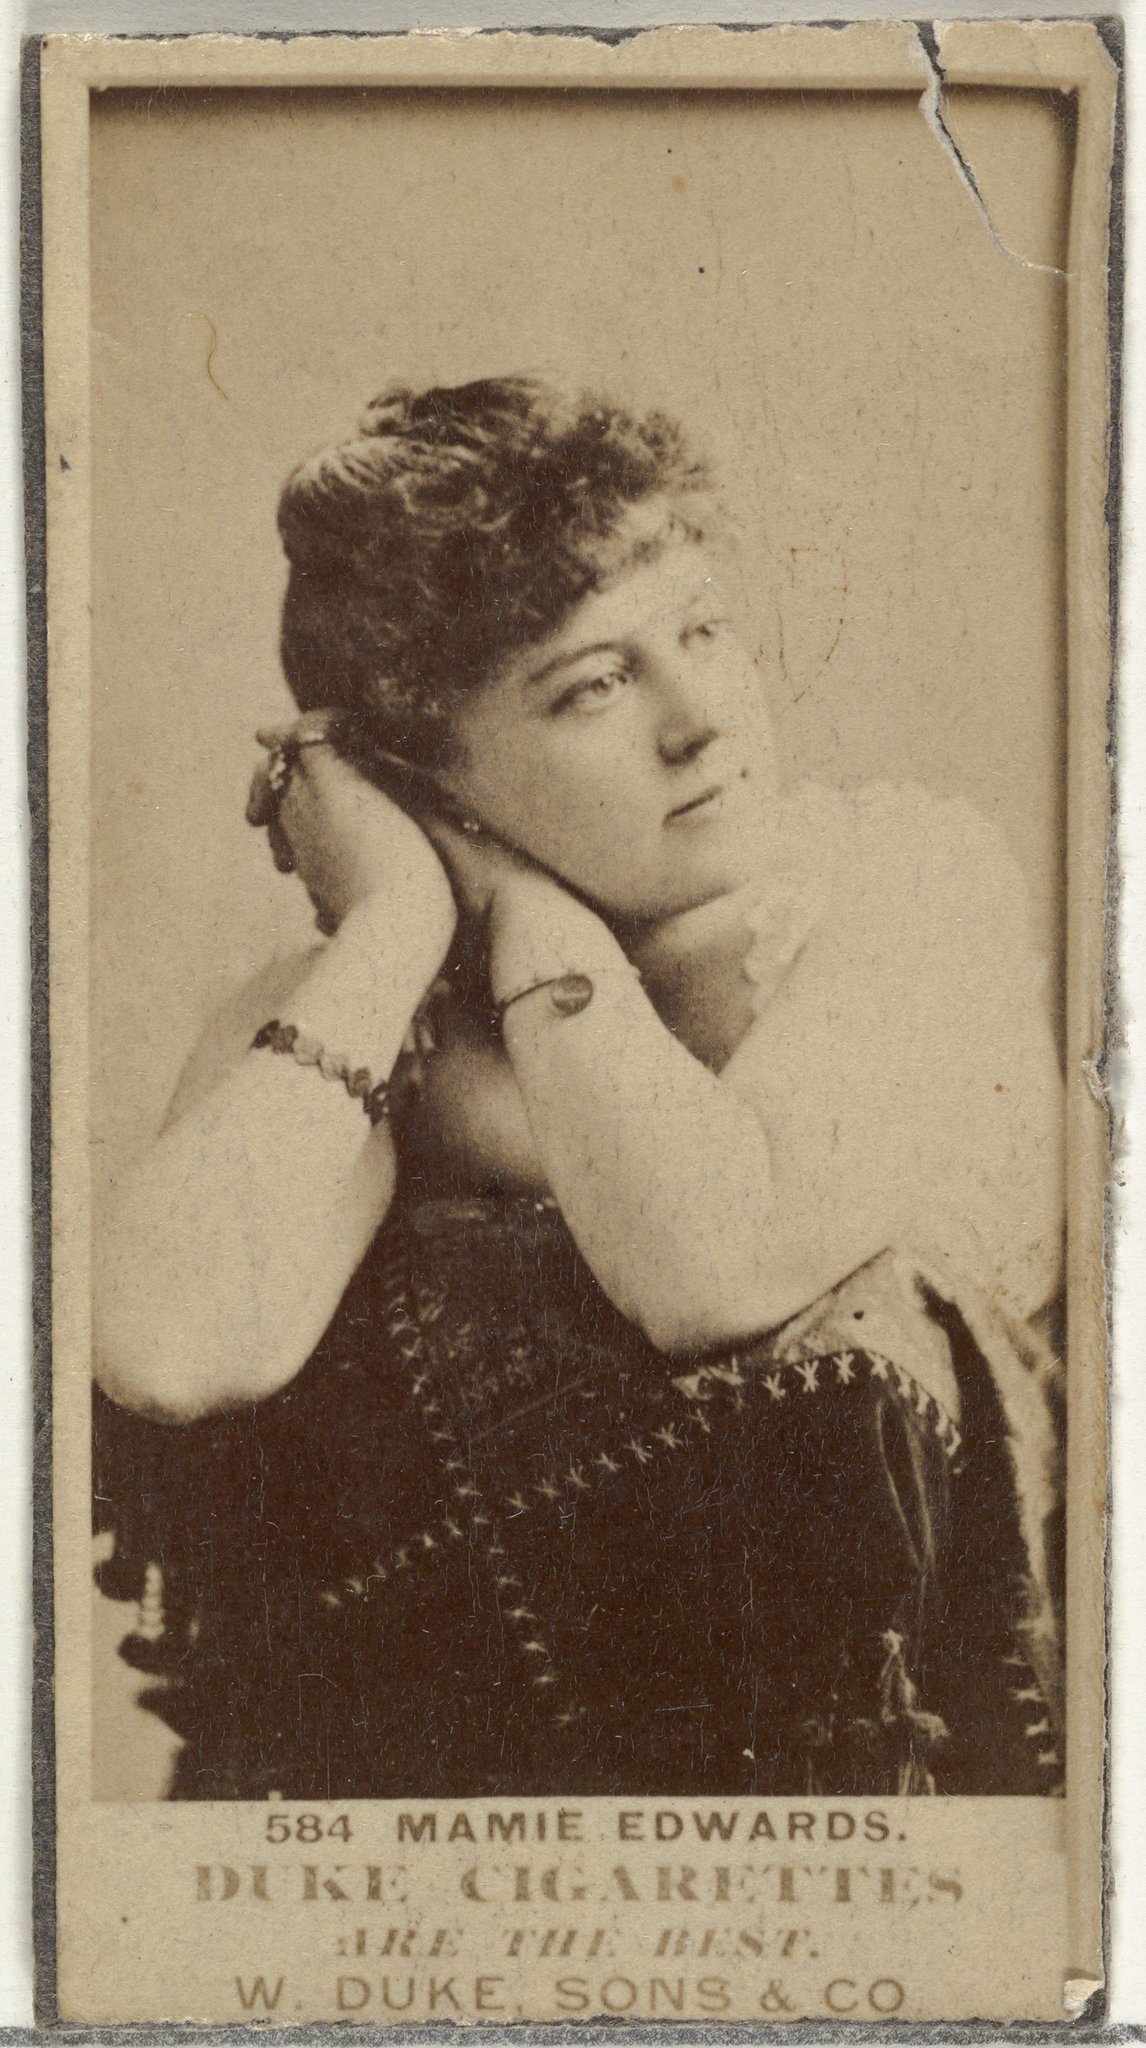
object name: photograph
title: Card Number 584, Mamie Edwards, from the Actors and Actresses series (N145-7) issued by Duke Sons & Co. to promote Duke Cigarettes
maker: w. duke, sons & co.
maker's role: publisher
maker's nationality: american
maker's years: 1870-1920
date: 1880-1889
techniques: albumen silver print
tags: portraits,women,actresses